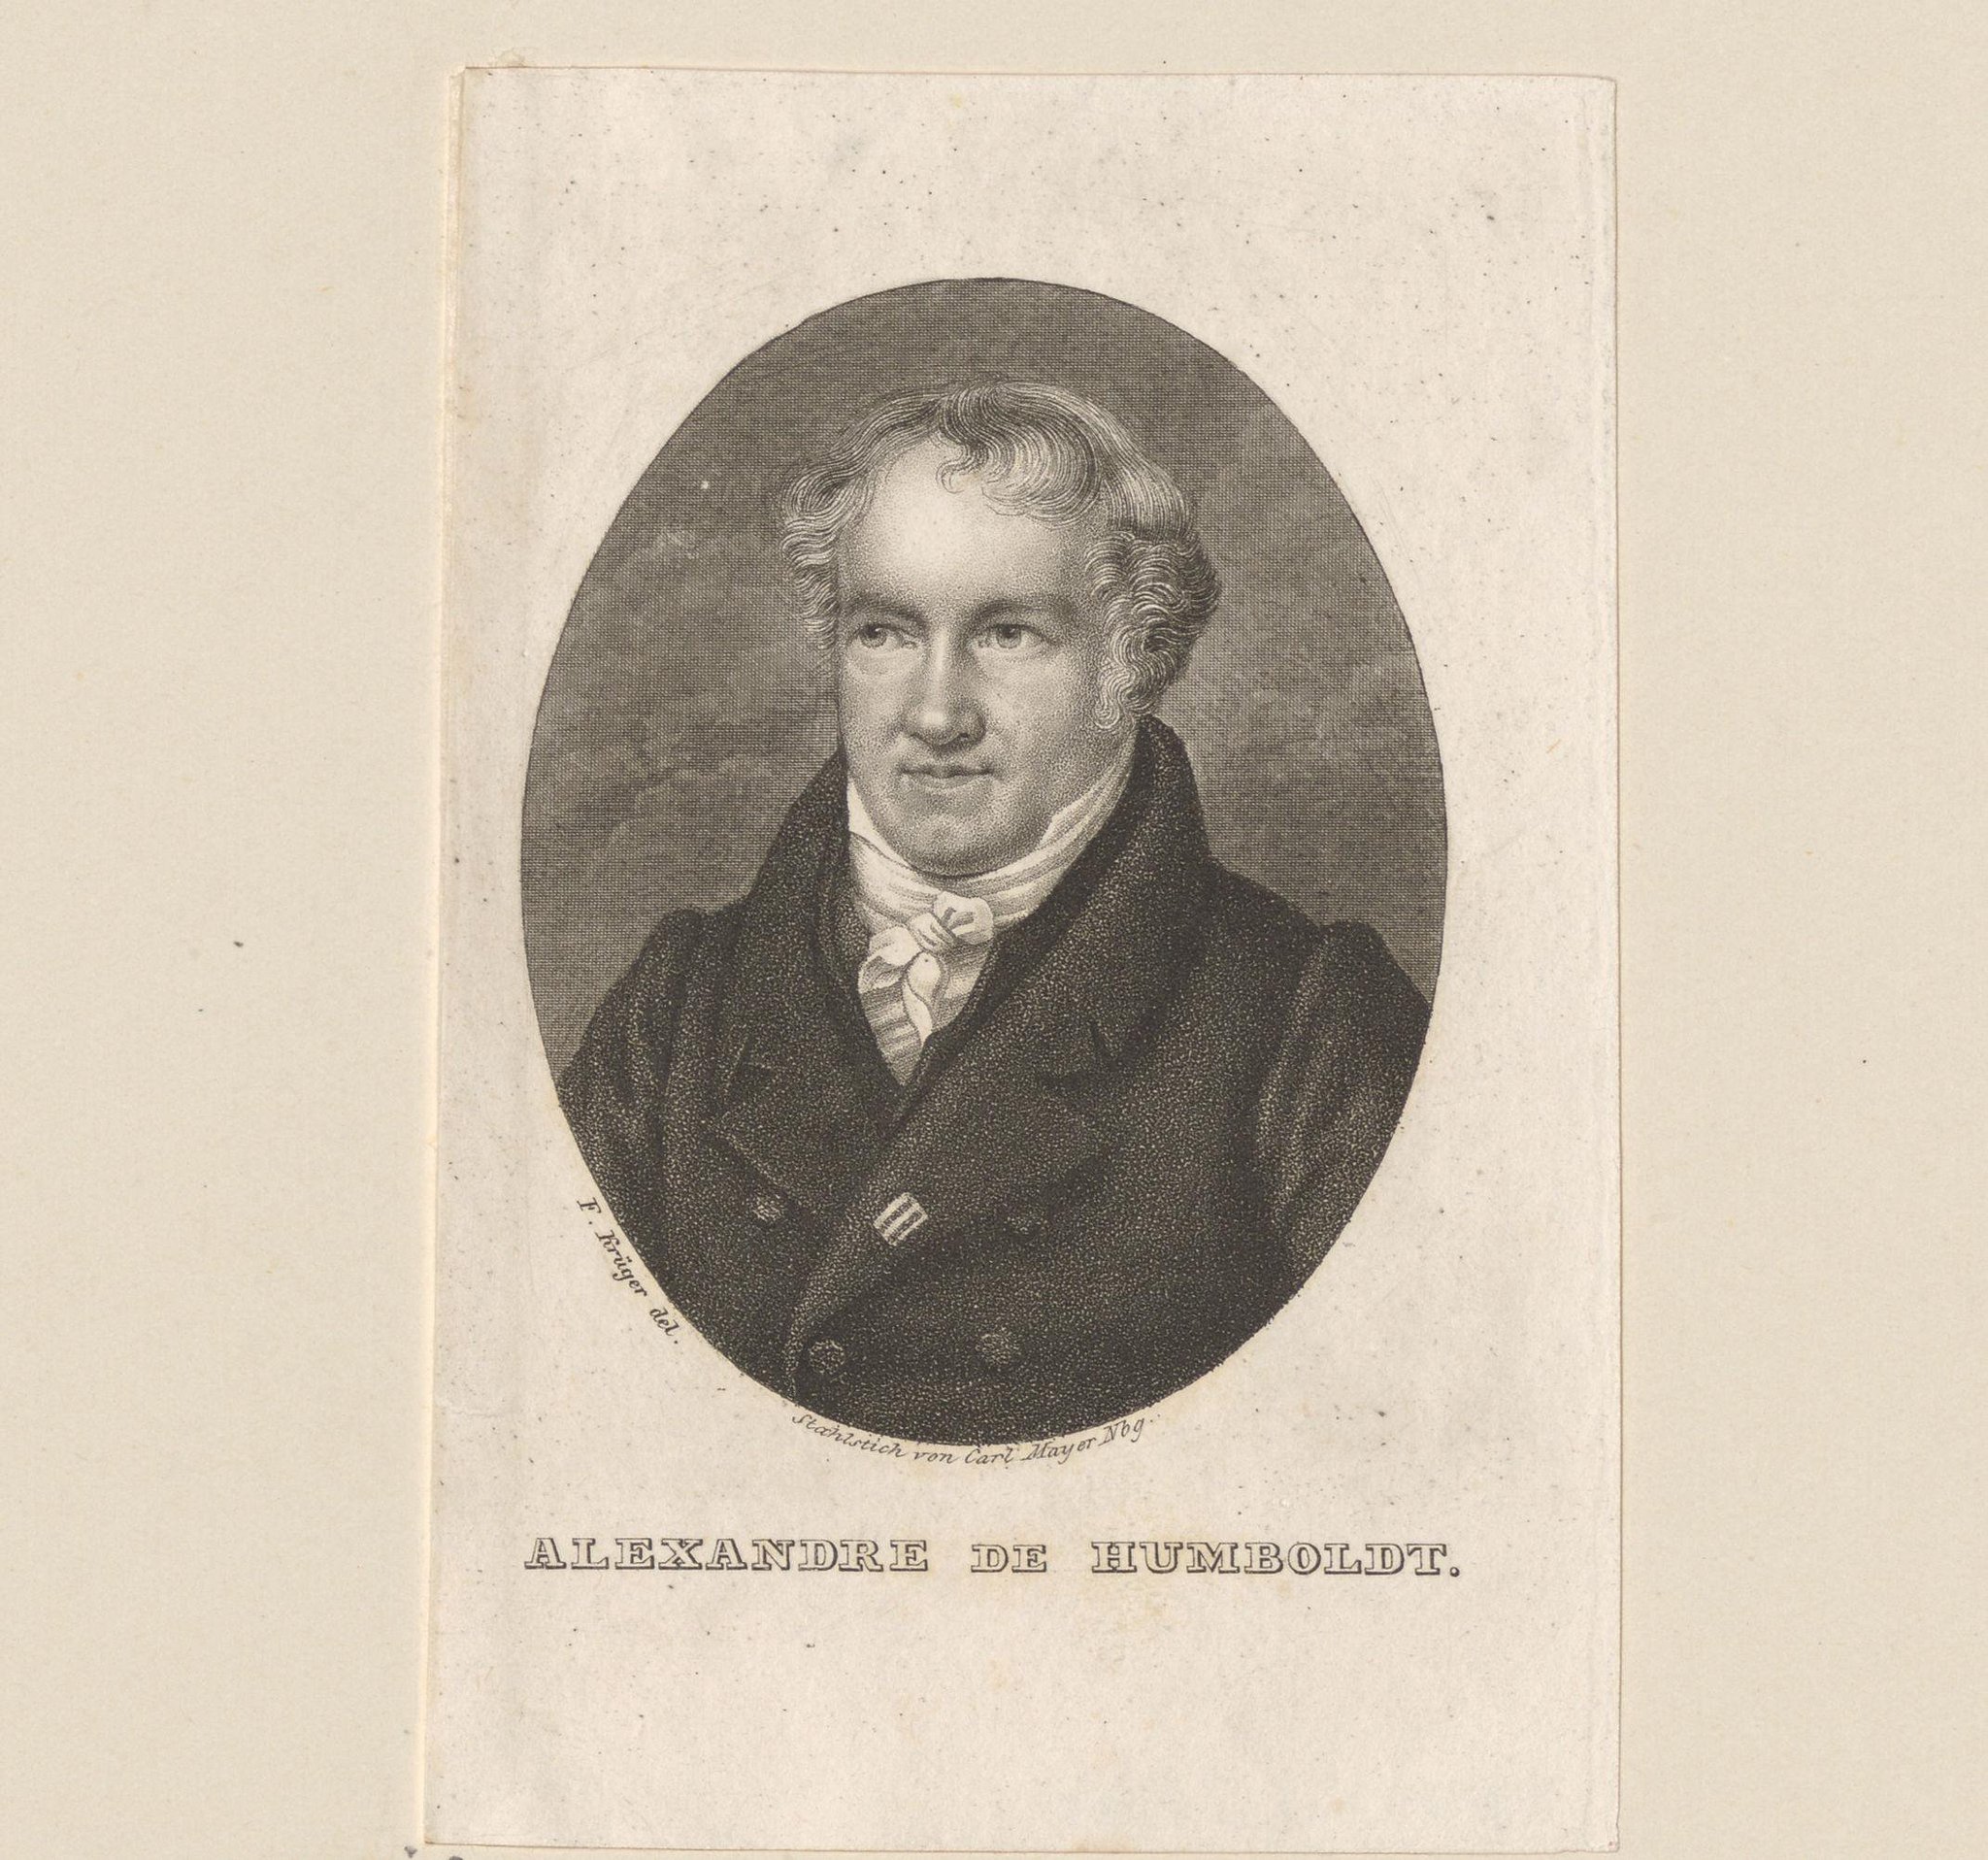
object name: print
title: Portret van Alexander von Humboldt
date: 1808-1868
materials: paper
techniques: engraving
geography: nuremberg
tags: berlin, traveler, historical persons, biology (+ portrait of scholar, scientist)